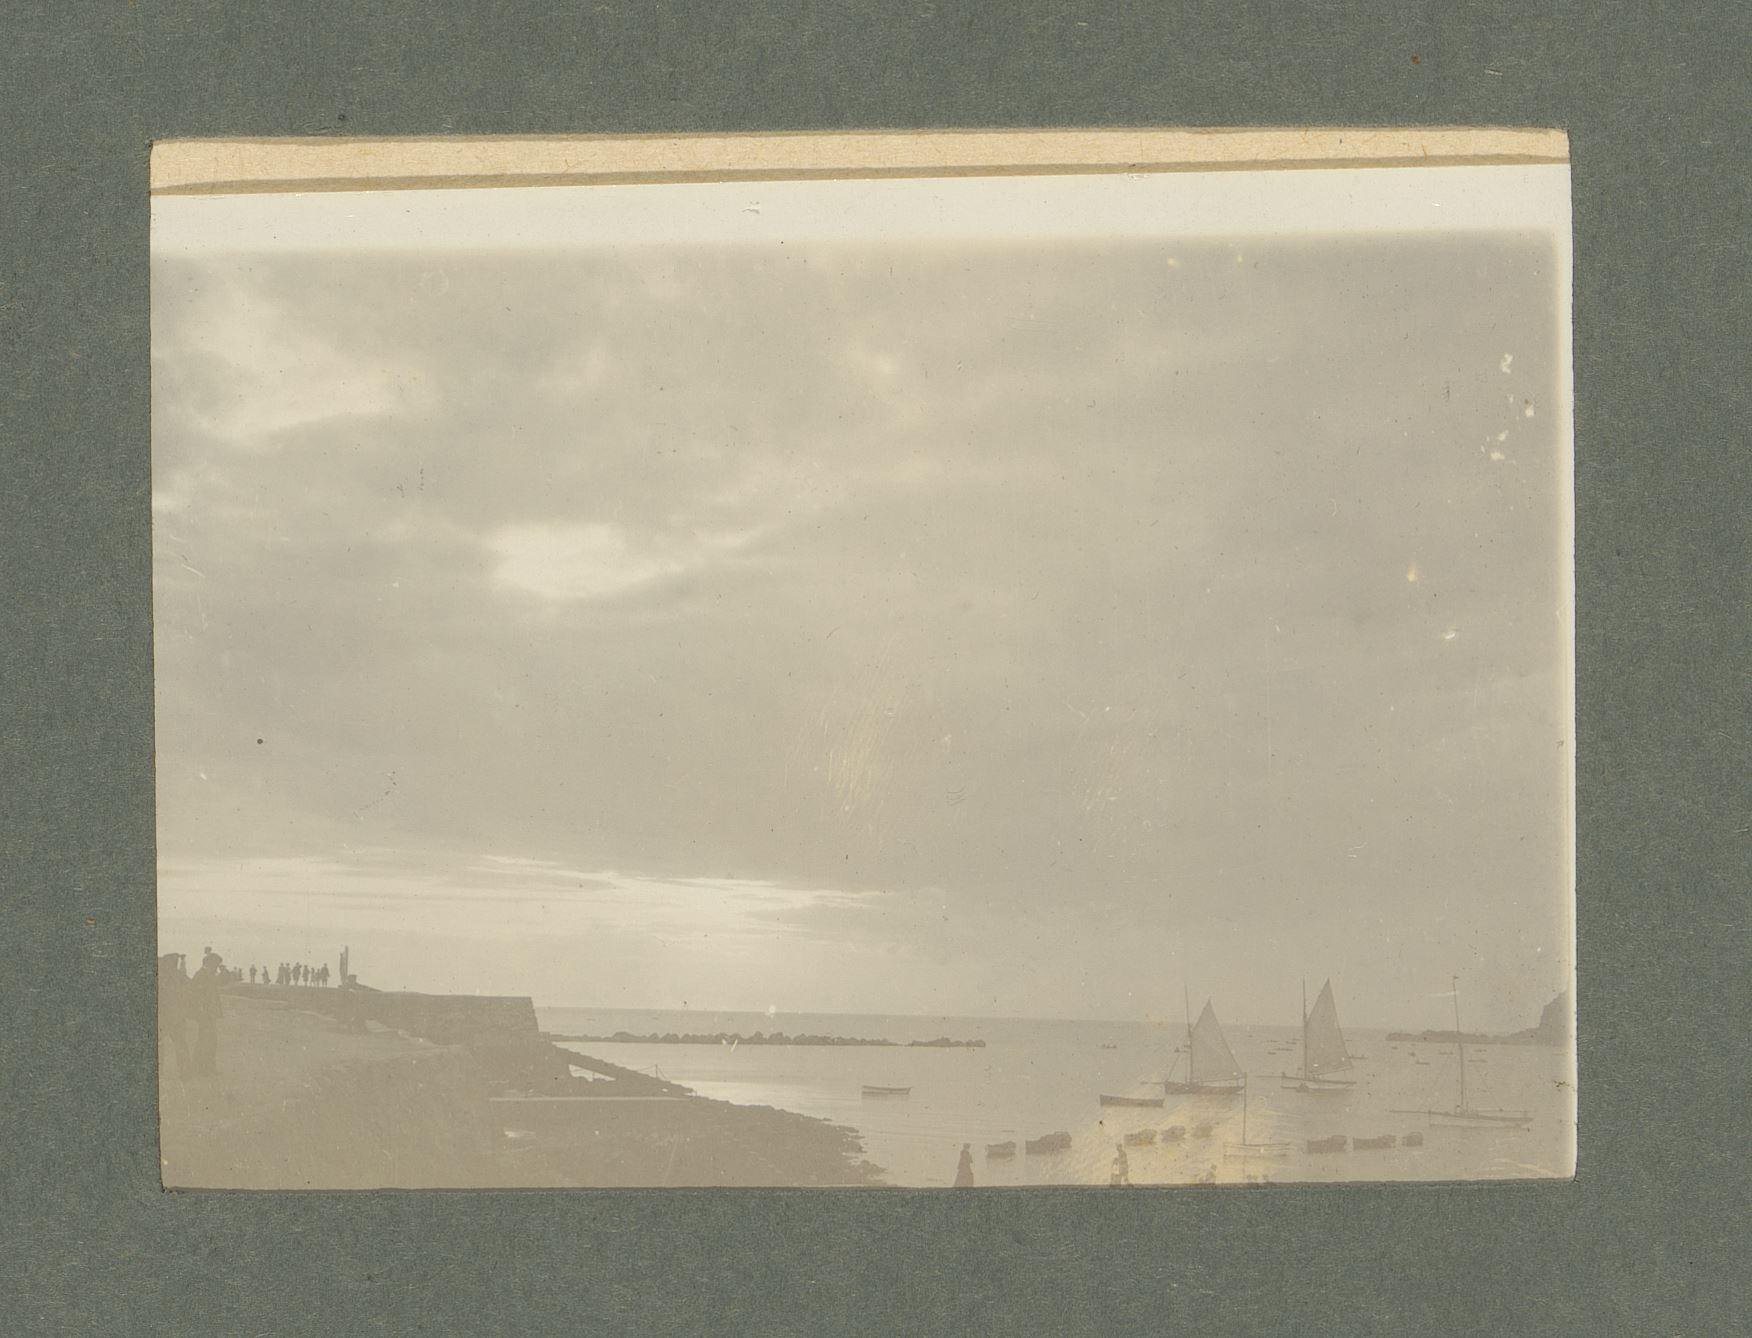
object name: photograph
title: Gezicht op zeilboten te water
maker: george hidderley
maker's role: fotograaf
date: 1920-1940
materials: photographic support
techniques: gelatin silver print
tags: sailing-ship, sailing-boat, landscapes with waters, waterscapes, seascapes (in the temperate zone)